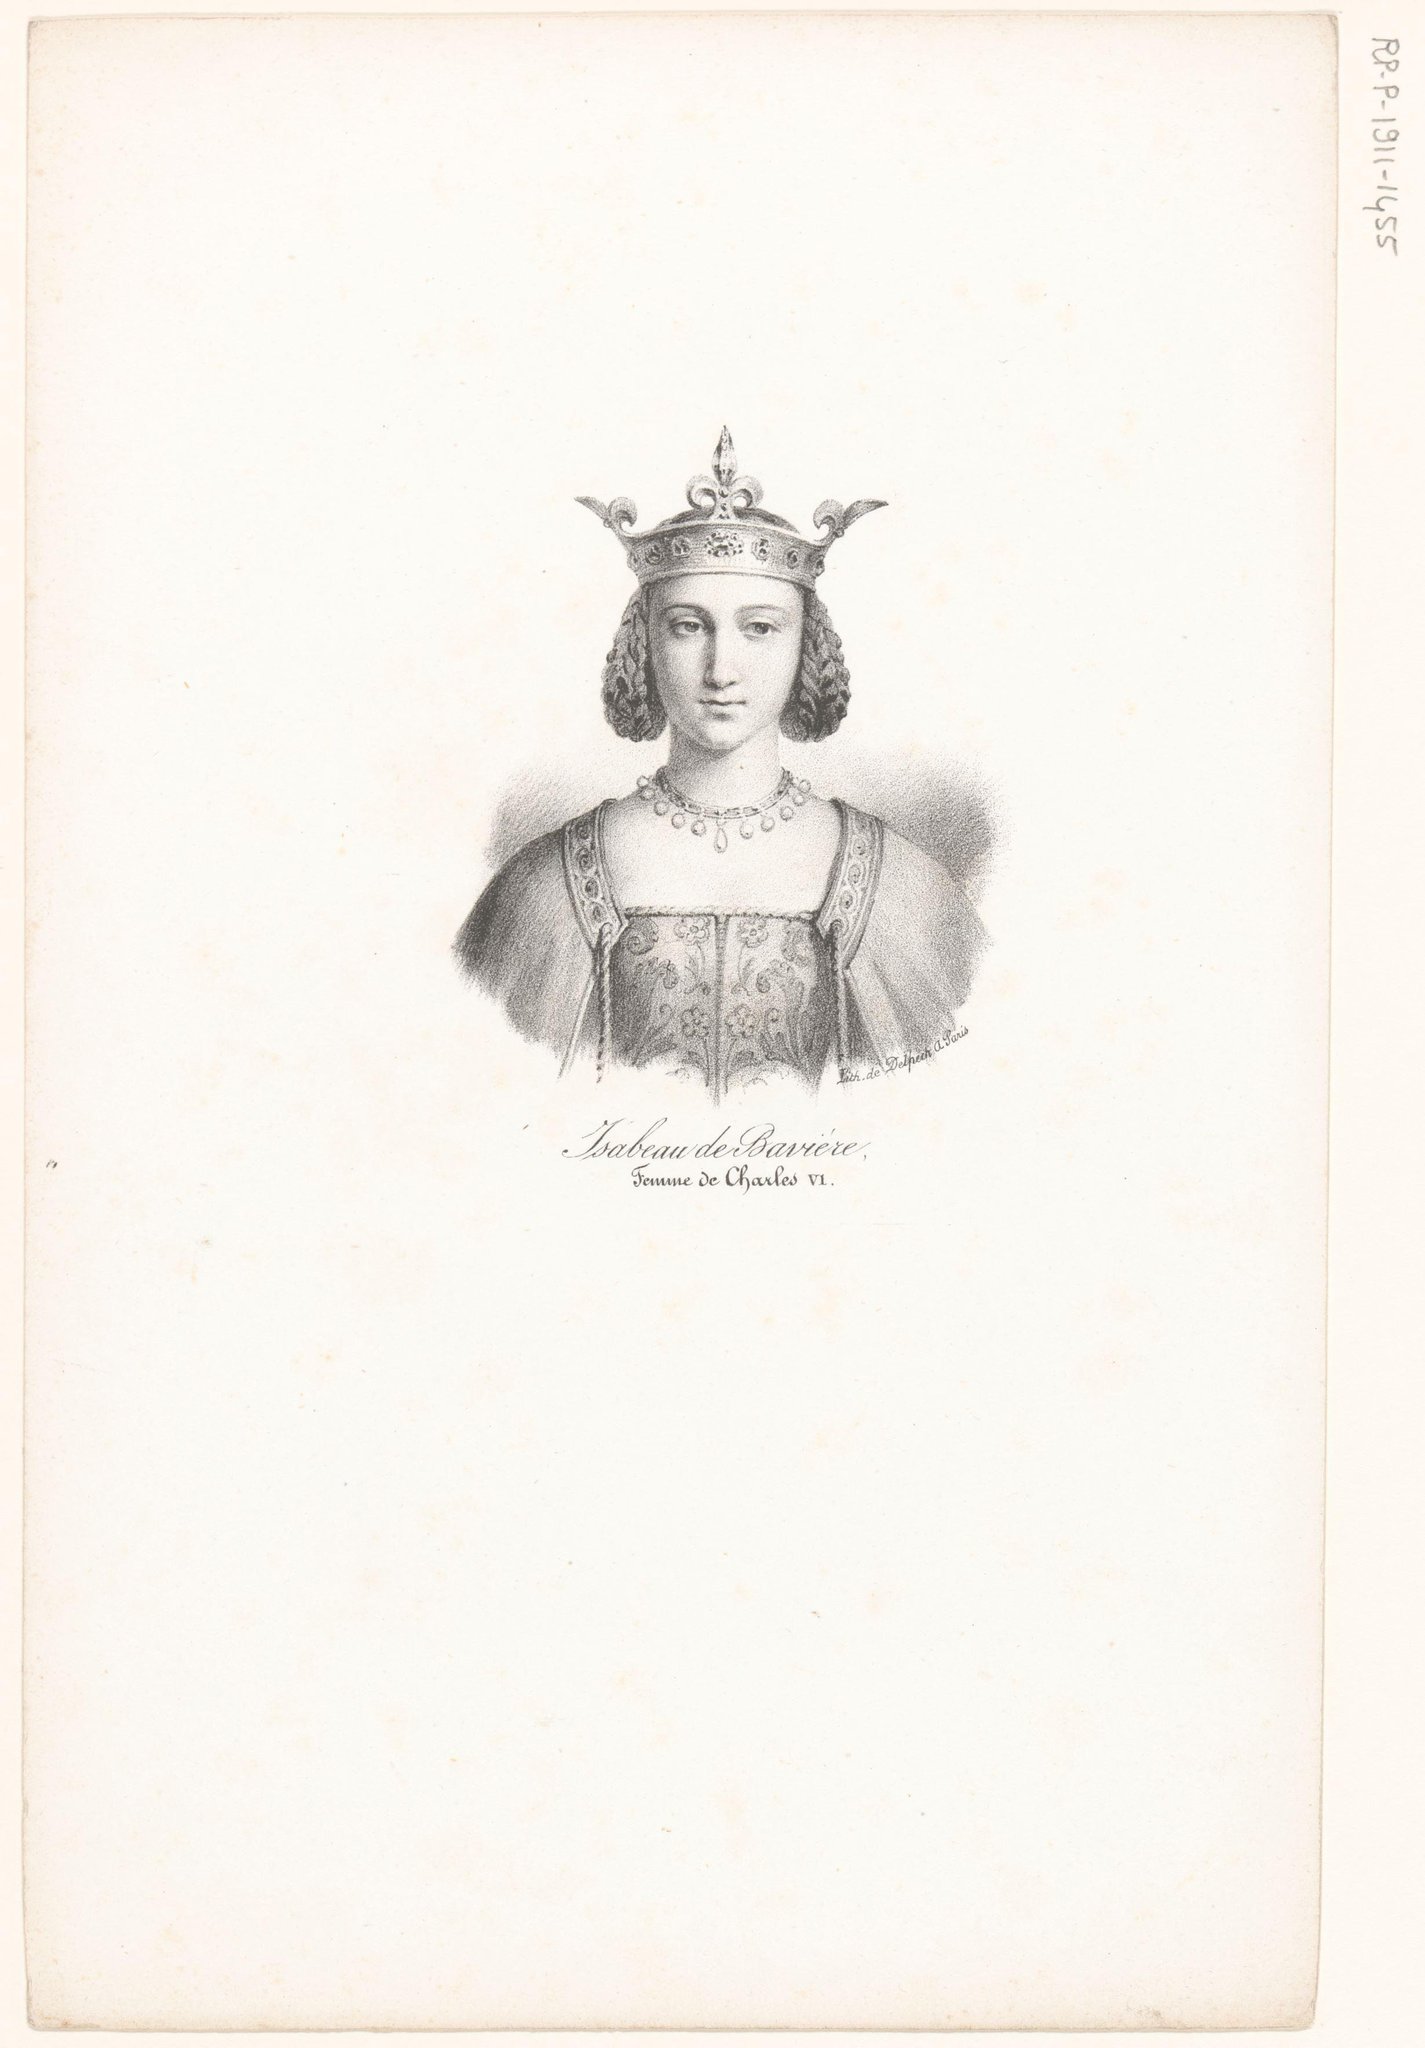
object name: print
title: Isabeau de Bavière, femme de Charles VI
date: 1818-1842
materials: paper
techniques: lithograph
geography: paris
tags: paris, historical persons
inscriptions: collector's mark: Lugt 2228a